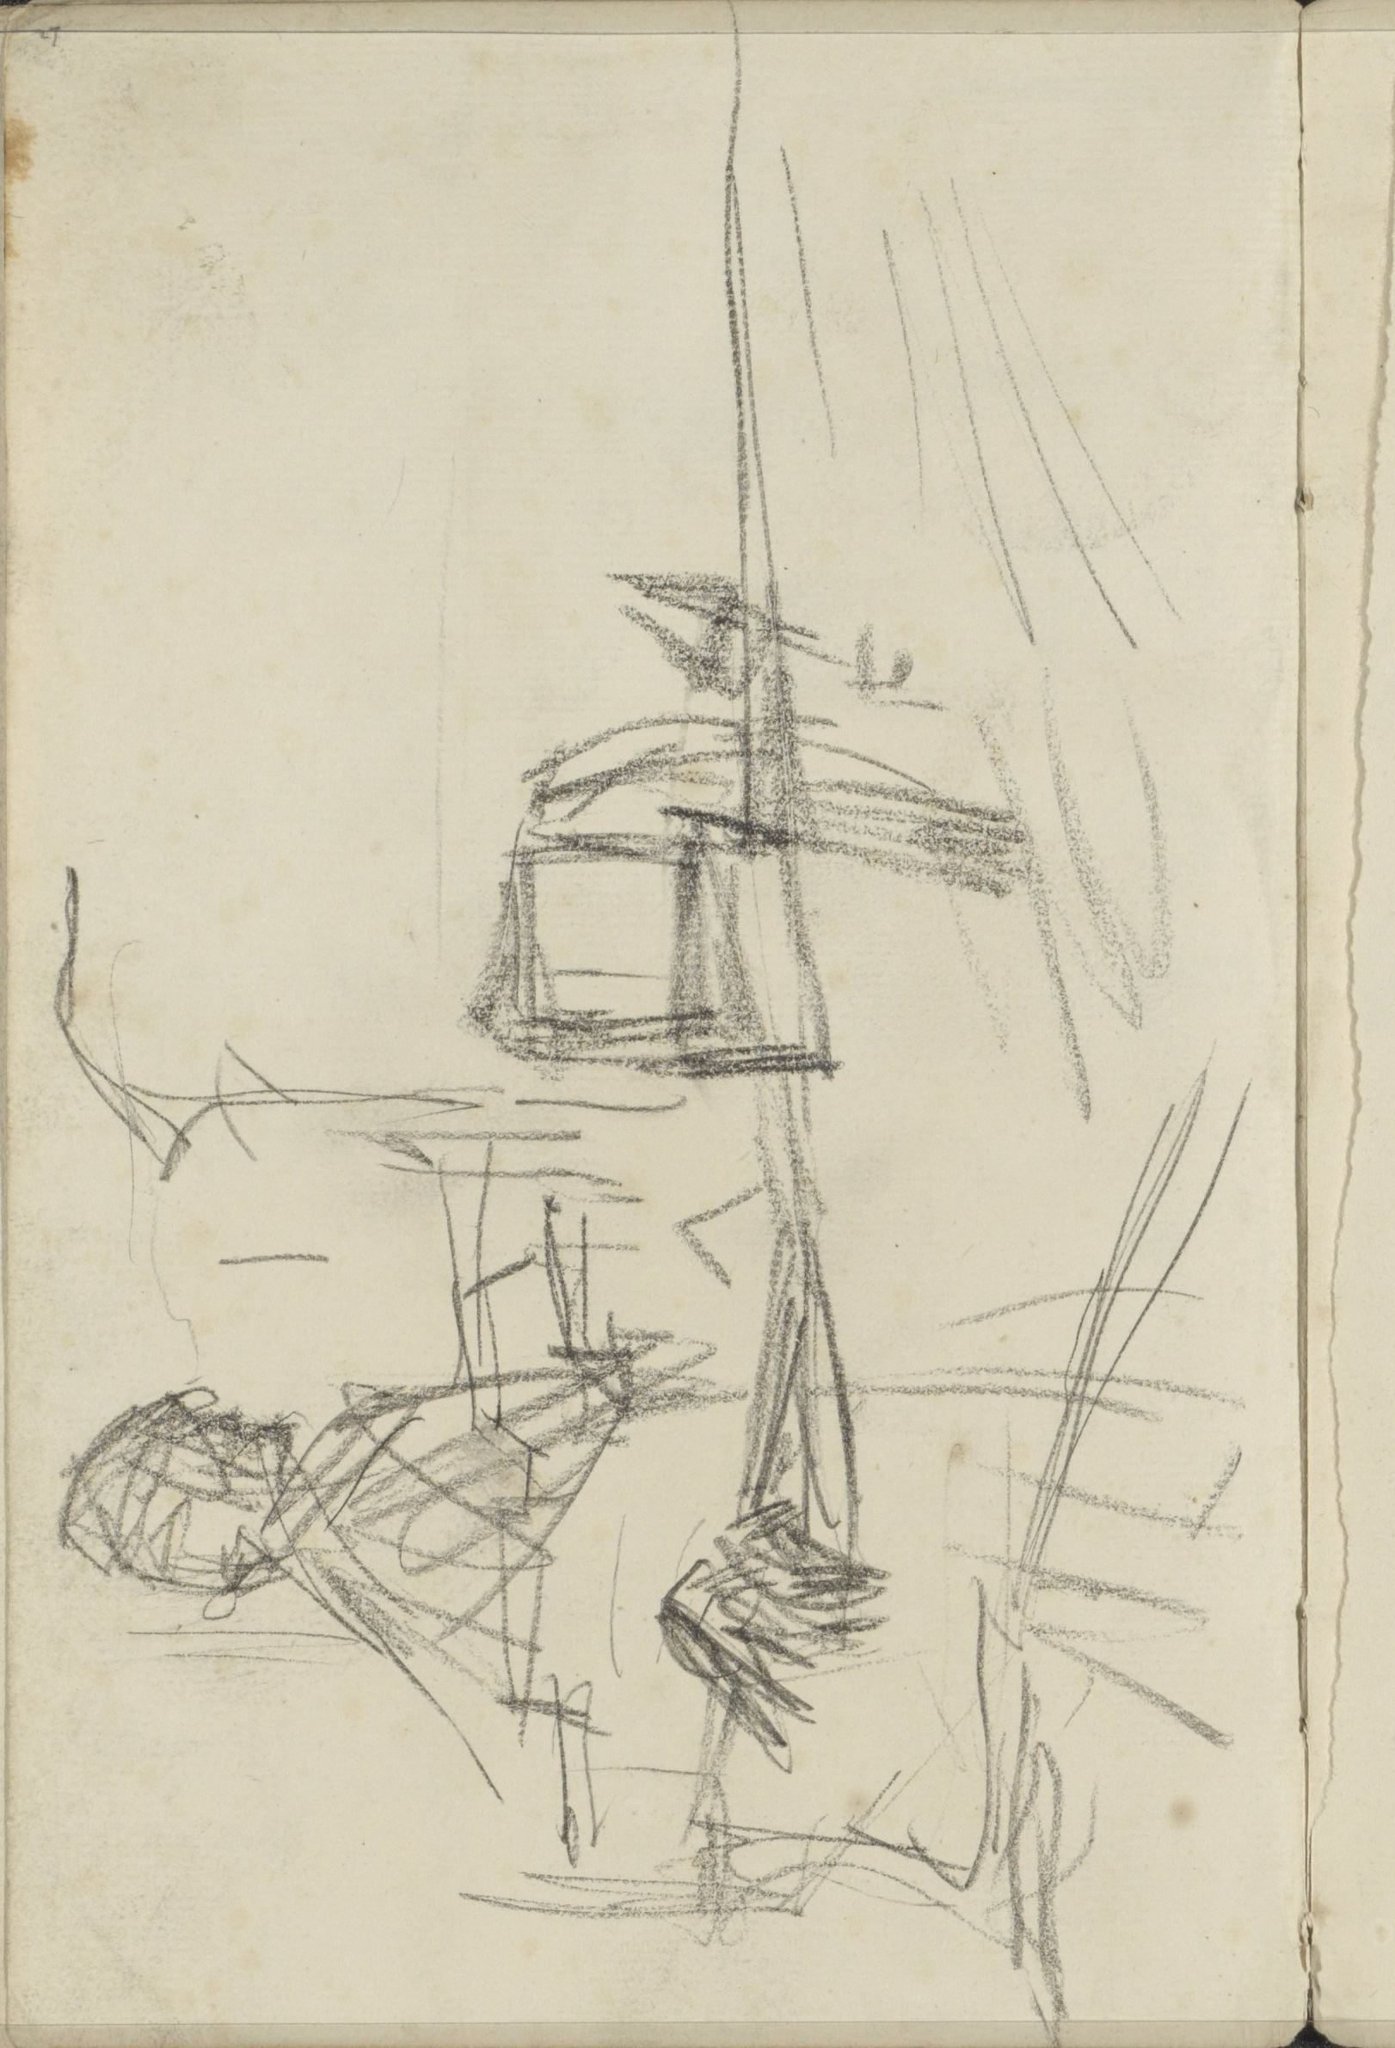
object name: sketchbook leaf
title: Figuurstudie en mogelijk een landschap met bebouwing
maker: george hendrik breitner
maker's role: draughtsman, painter, print maker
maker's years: 1857-1923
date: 1887-1891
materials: chalk, paper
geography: amsterdam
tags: landscapes, adult man, civic architecture; edifices; dwellings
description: Pagina 27 uit een schetsboek met 17 bladen.